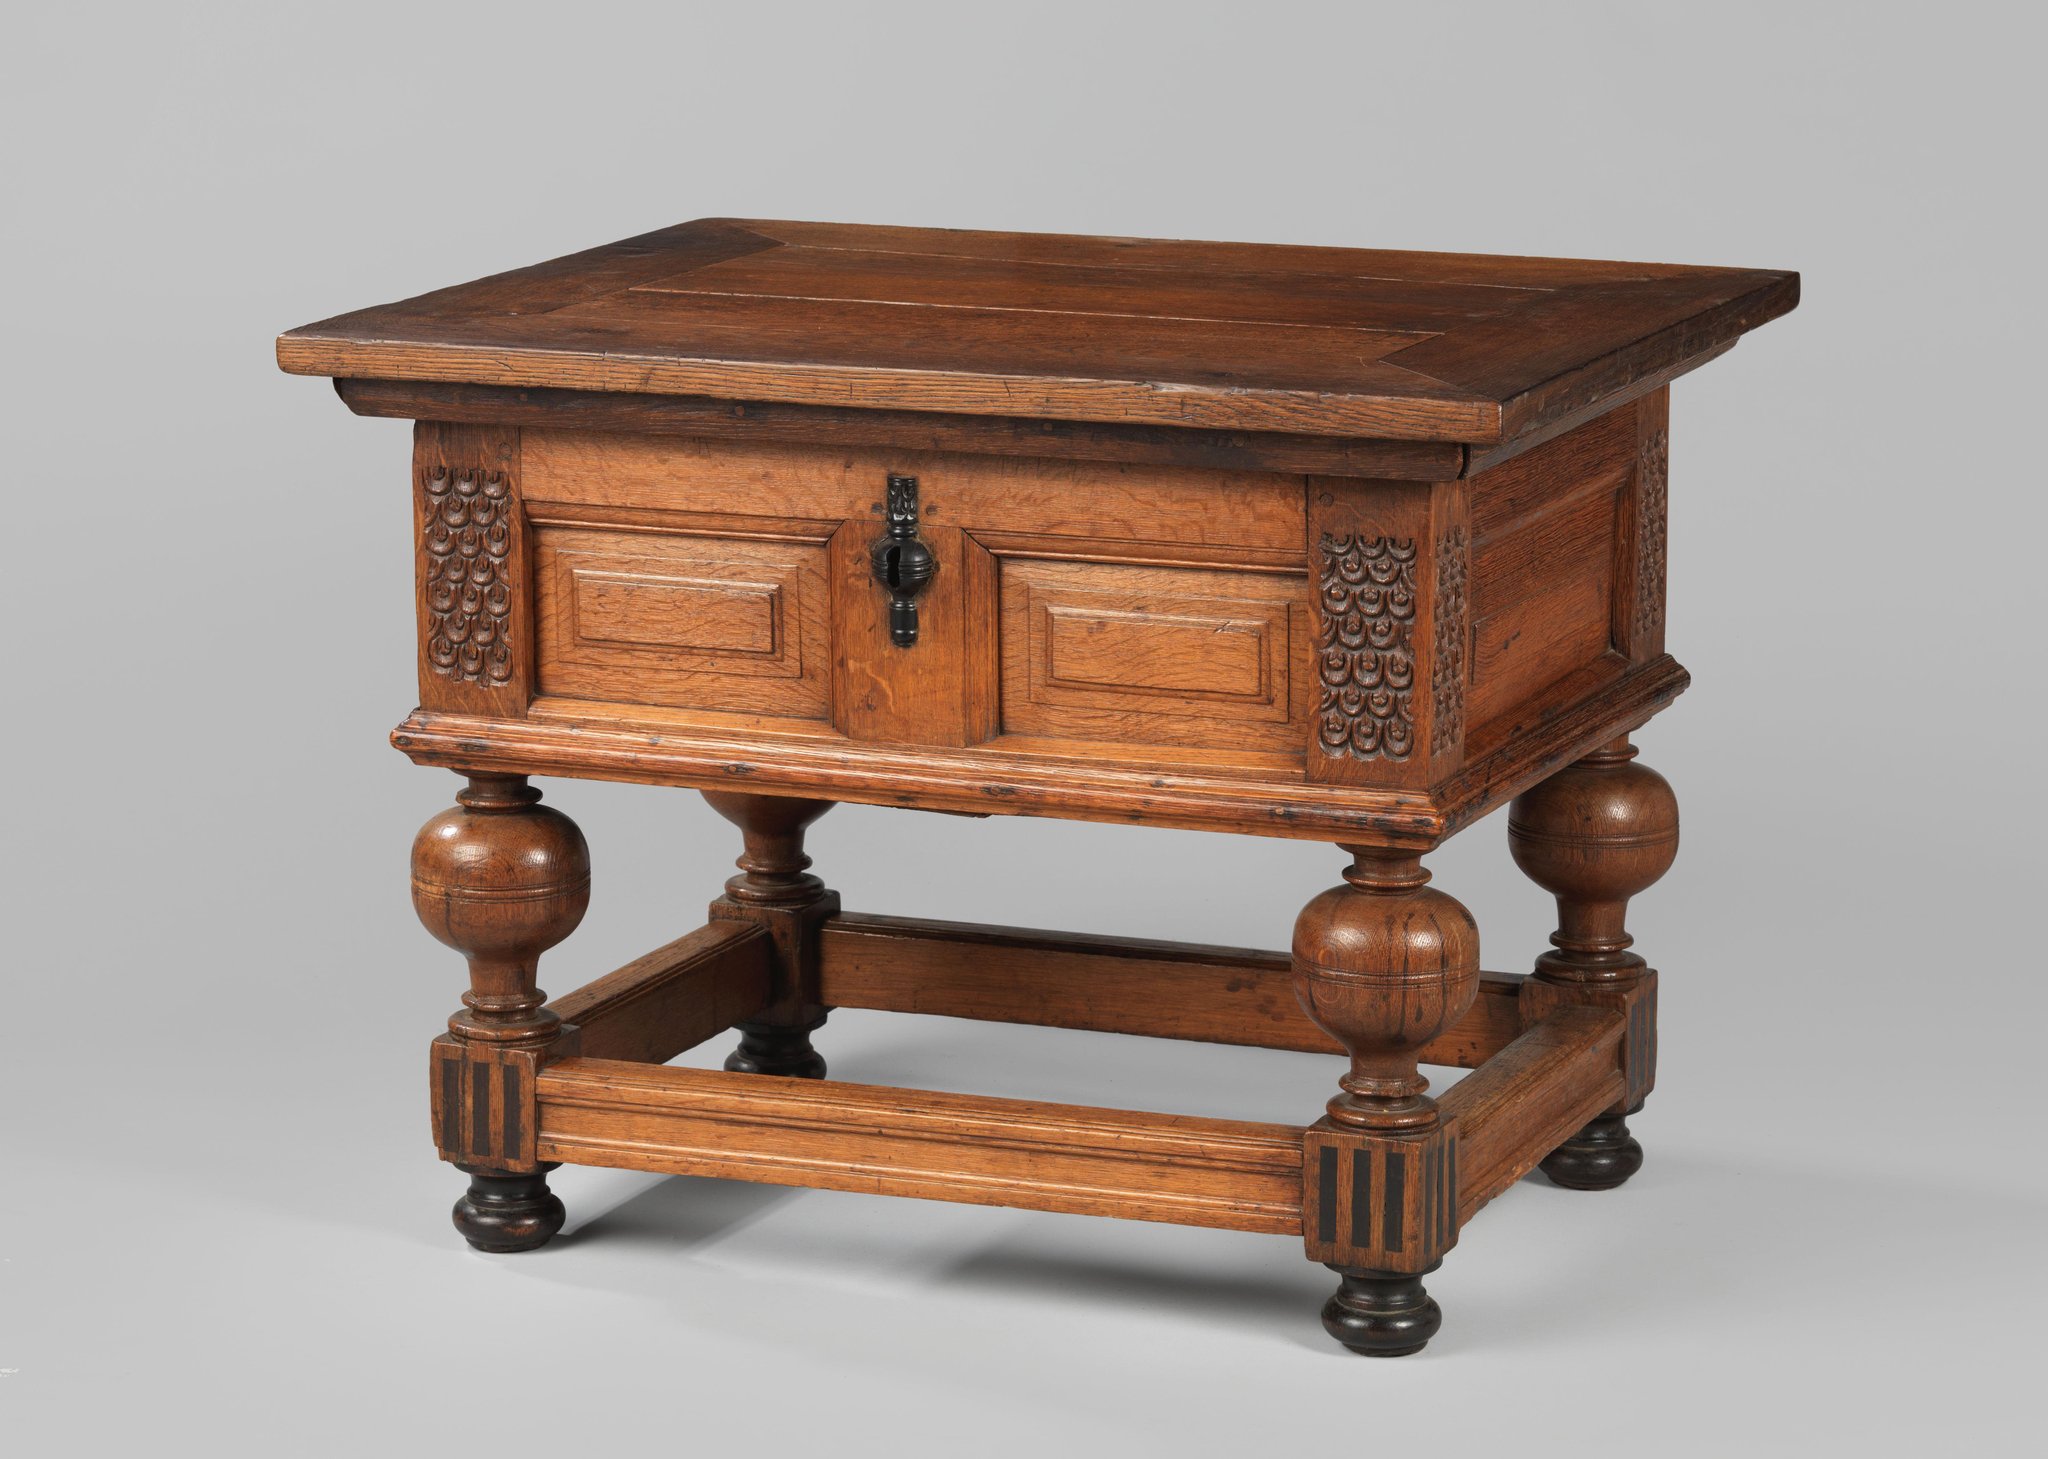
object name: furniture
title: Betaaltafel waarvan de hoekstijlen boven de poten zijn geschubt met geldstukken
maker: Anonymous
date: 1640-1660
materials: wood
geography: netherlands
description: Eikenhouten betaaltafel, ingelegd met palissanderhout. De balpoten rusten op platte klossen en zijn ter hoogte van de huizen, met ebbenhouten cannelures, door staande geprofileerde regels verbonden. Onder het schuifblad bevindt zich een afgeschuinde regel, waaronder het kistgedeelte op plint. De lange zijden vertonen twee vlakke kussenpanelen; de korte vertoont er één. De hoekstijlen boven de poten zijn geschubt met geldstukken. Het blad is in verstek gelijst om een middenveld van drie delen.